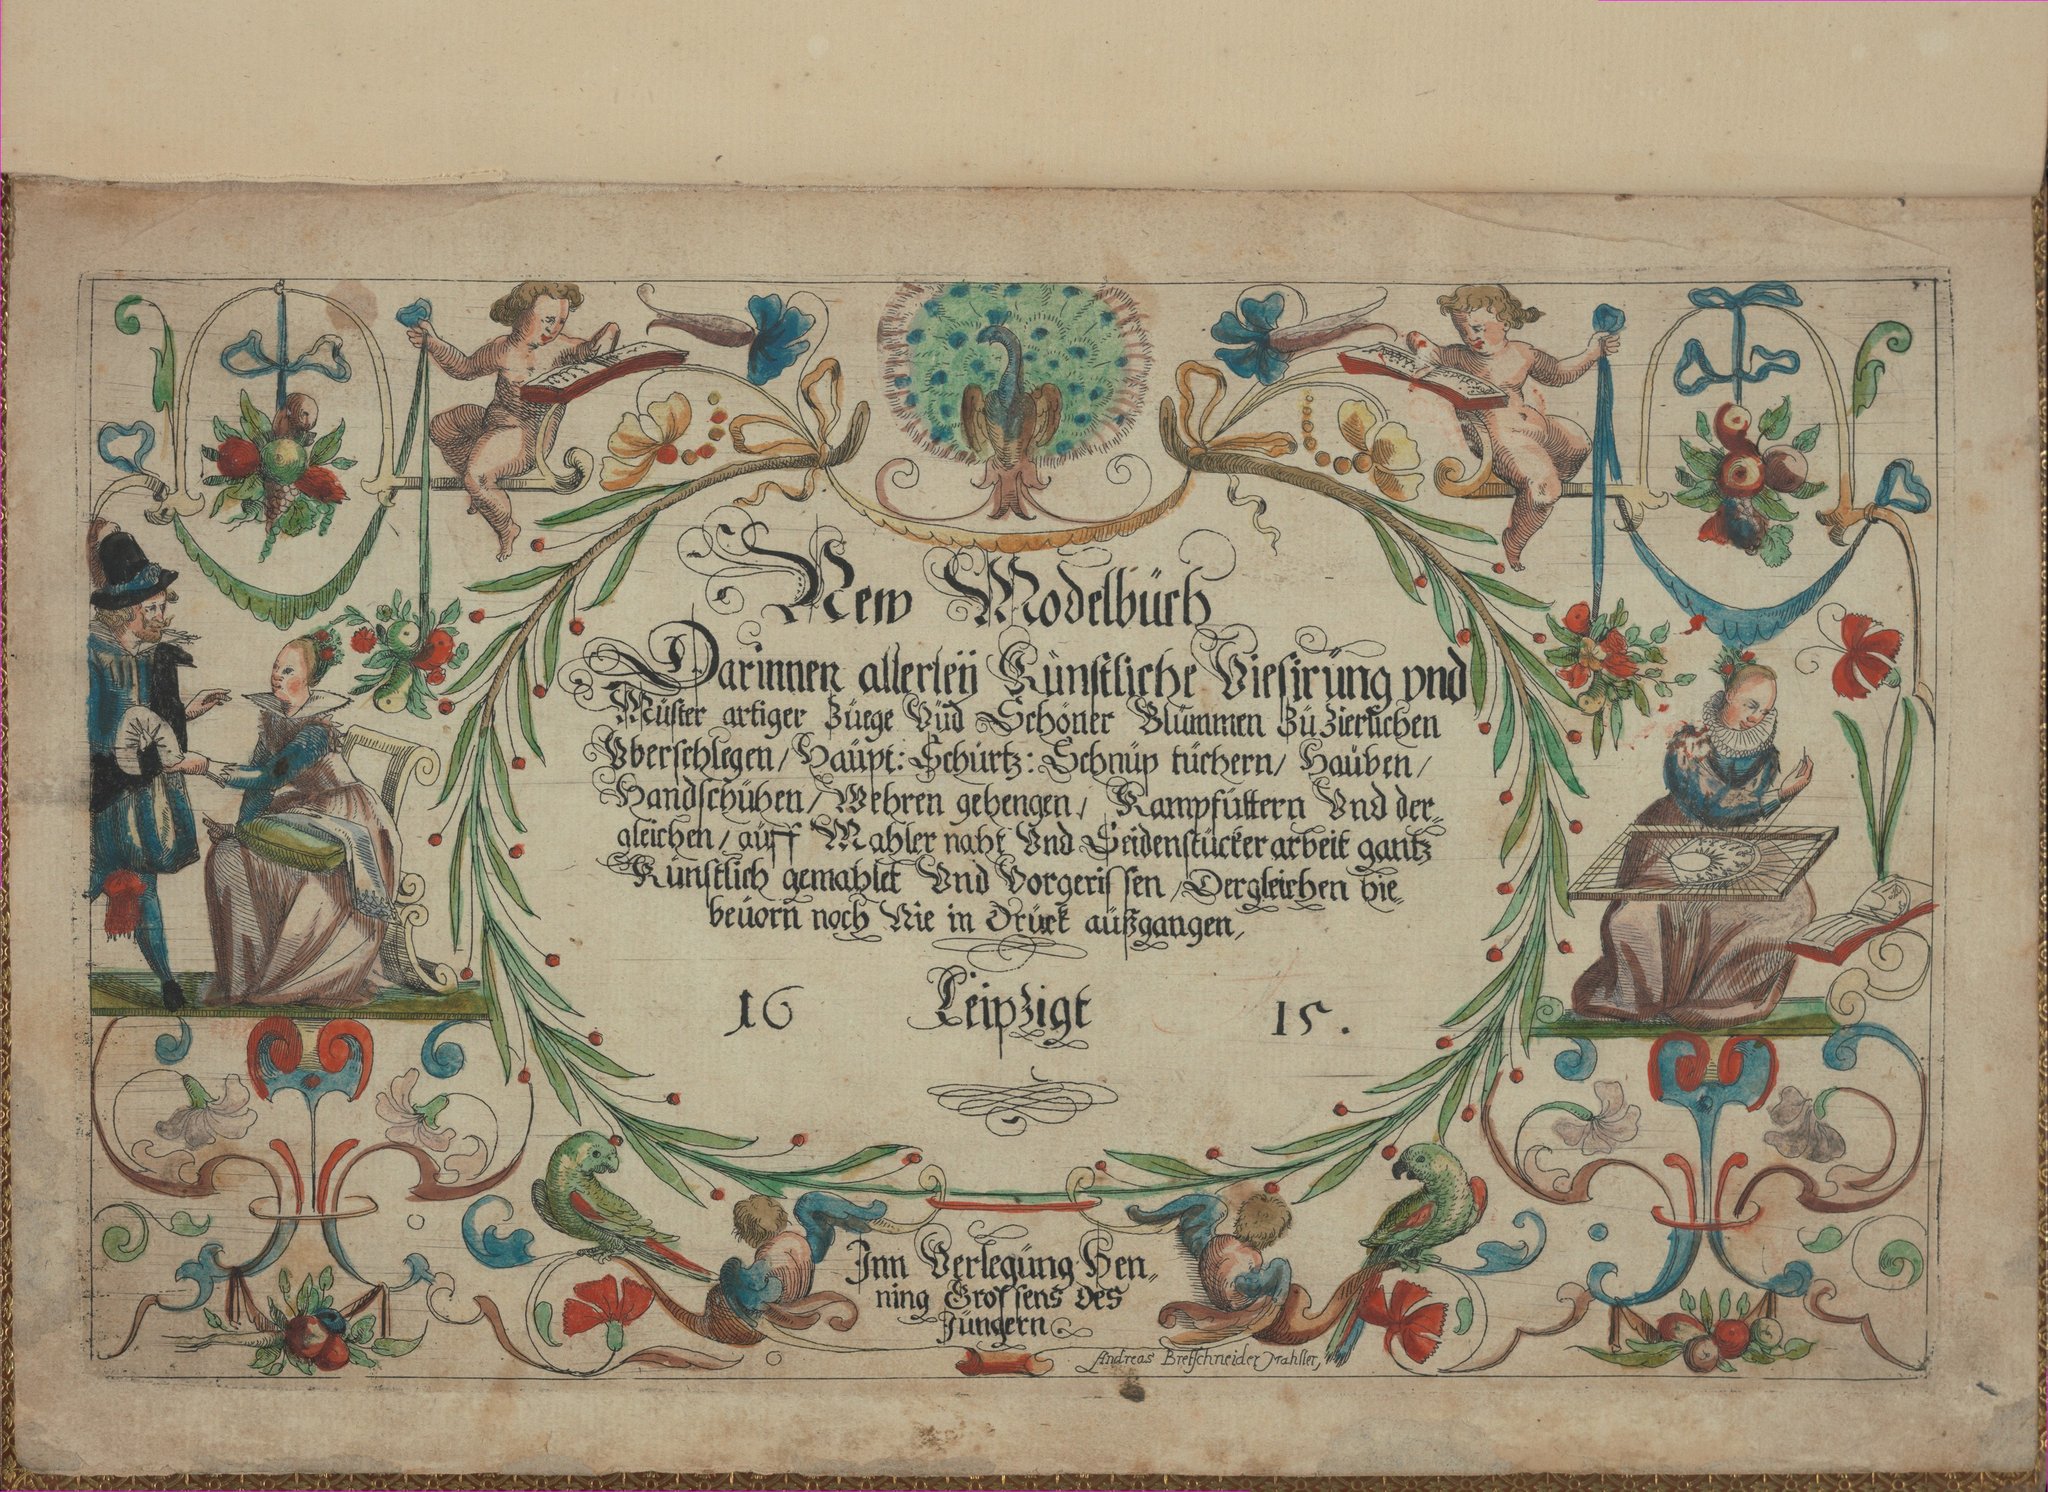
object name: book print ornament architecture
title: New Modelbüch (Title page, 1r)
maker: andreas bretschneider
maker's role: designer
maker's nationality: german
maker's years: 1573-1645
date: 1615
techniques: etching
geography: germany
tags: birds,men,women,wreaths